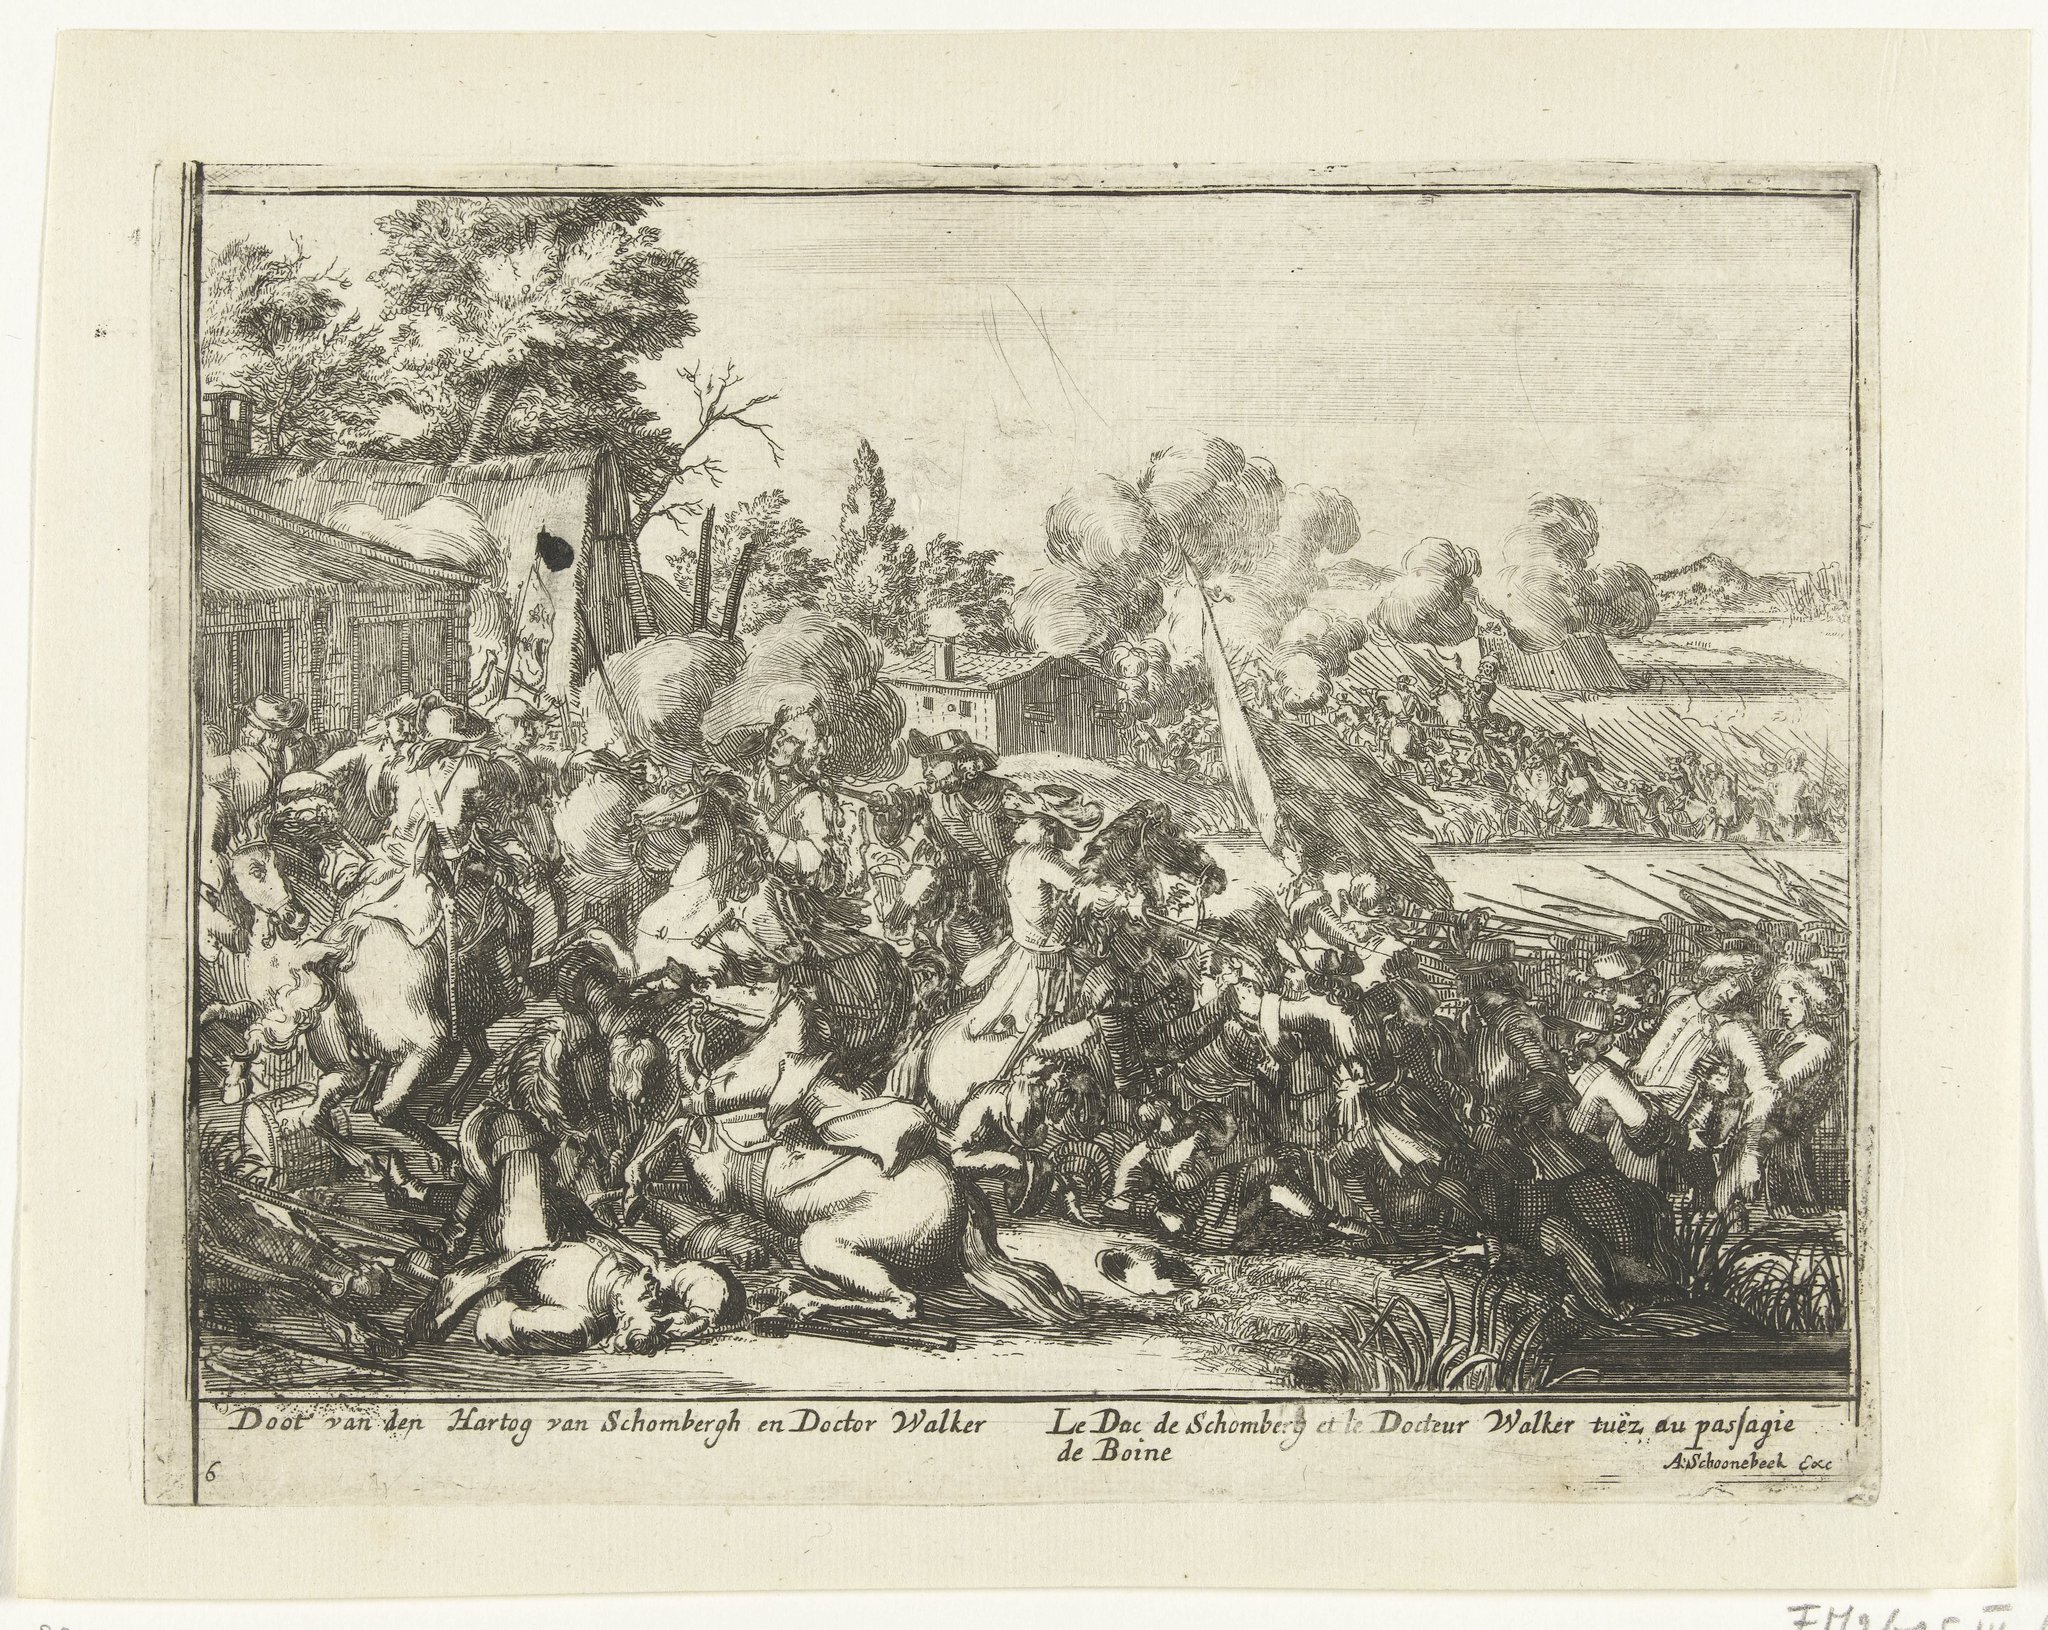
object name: print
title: De hertog van Schomberg sneuvelt in de slag bij de Boyne, 1690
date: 1691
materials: paper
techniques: etching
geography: amsterdam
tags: battle (+ land forces)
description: De hertog van Schomberg sneuvelt in de slag bij de Boyne op 11 juli 1690. Plaat nr. 6 in de serie 'Engelands schouwtoneel' over de oorlog tussen Willem III en Jacobus II in de jaren 1690-1691 na de Glorious Revolution, (derde deel). Met onderschriften in het Nederlands en Frans.